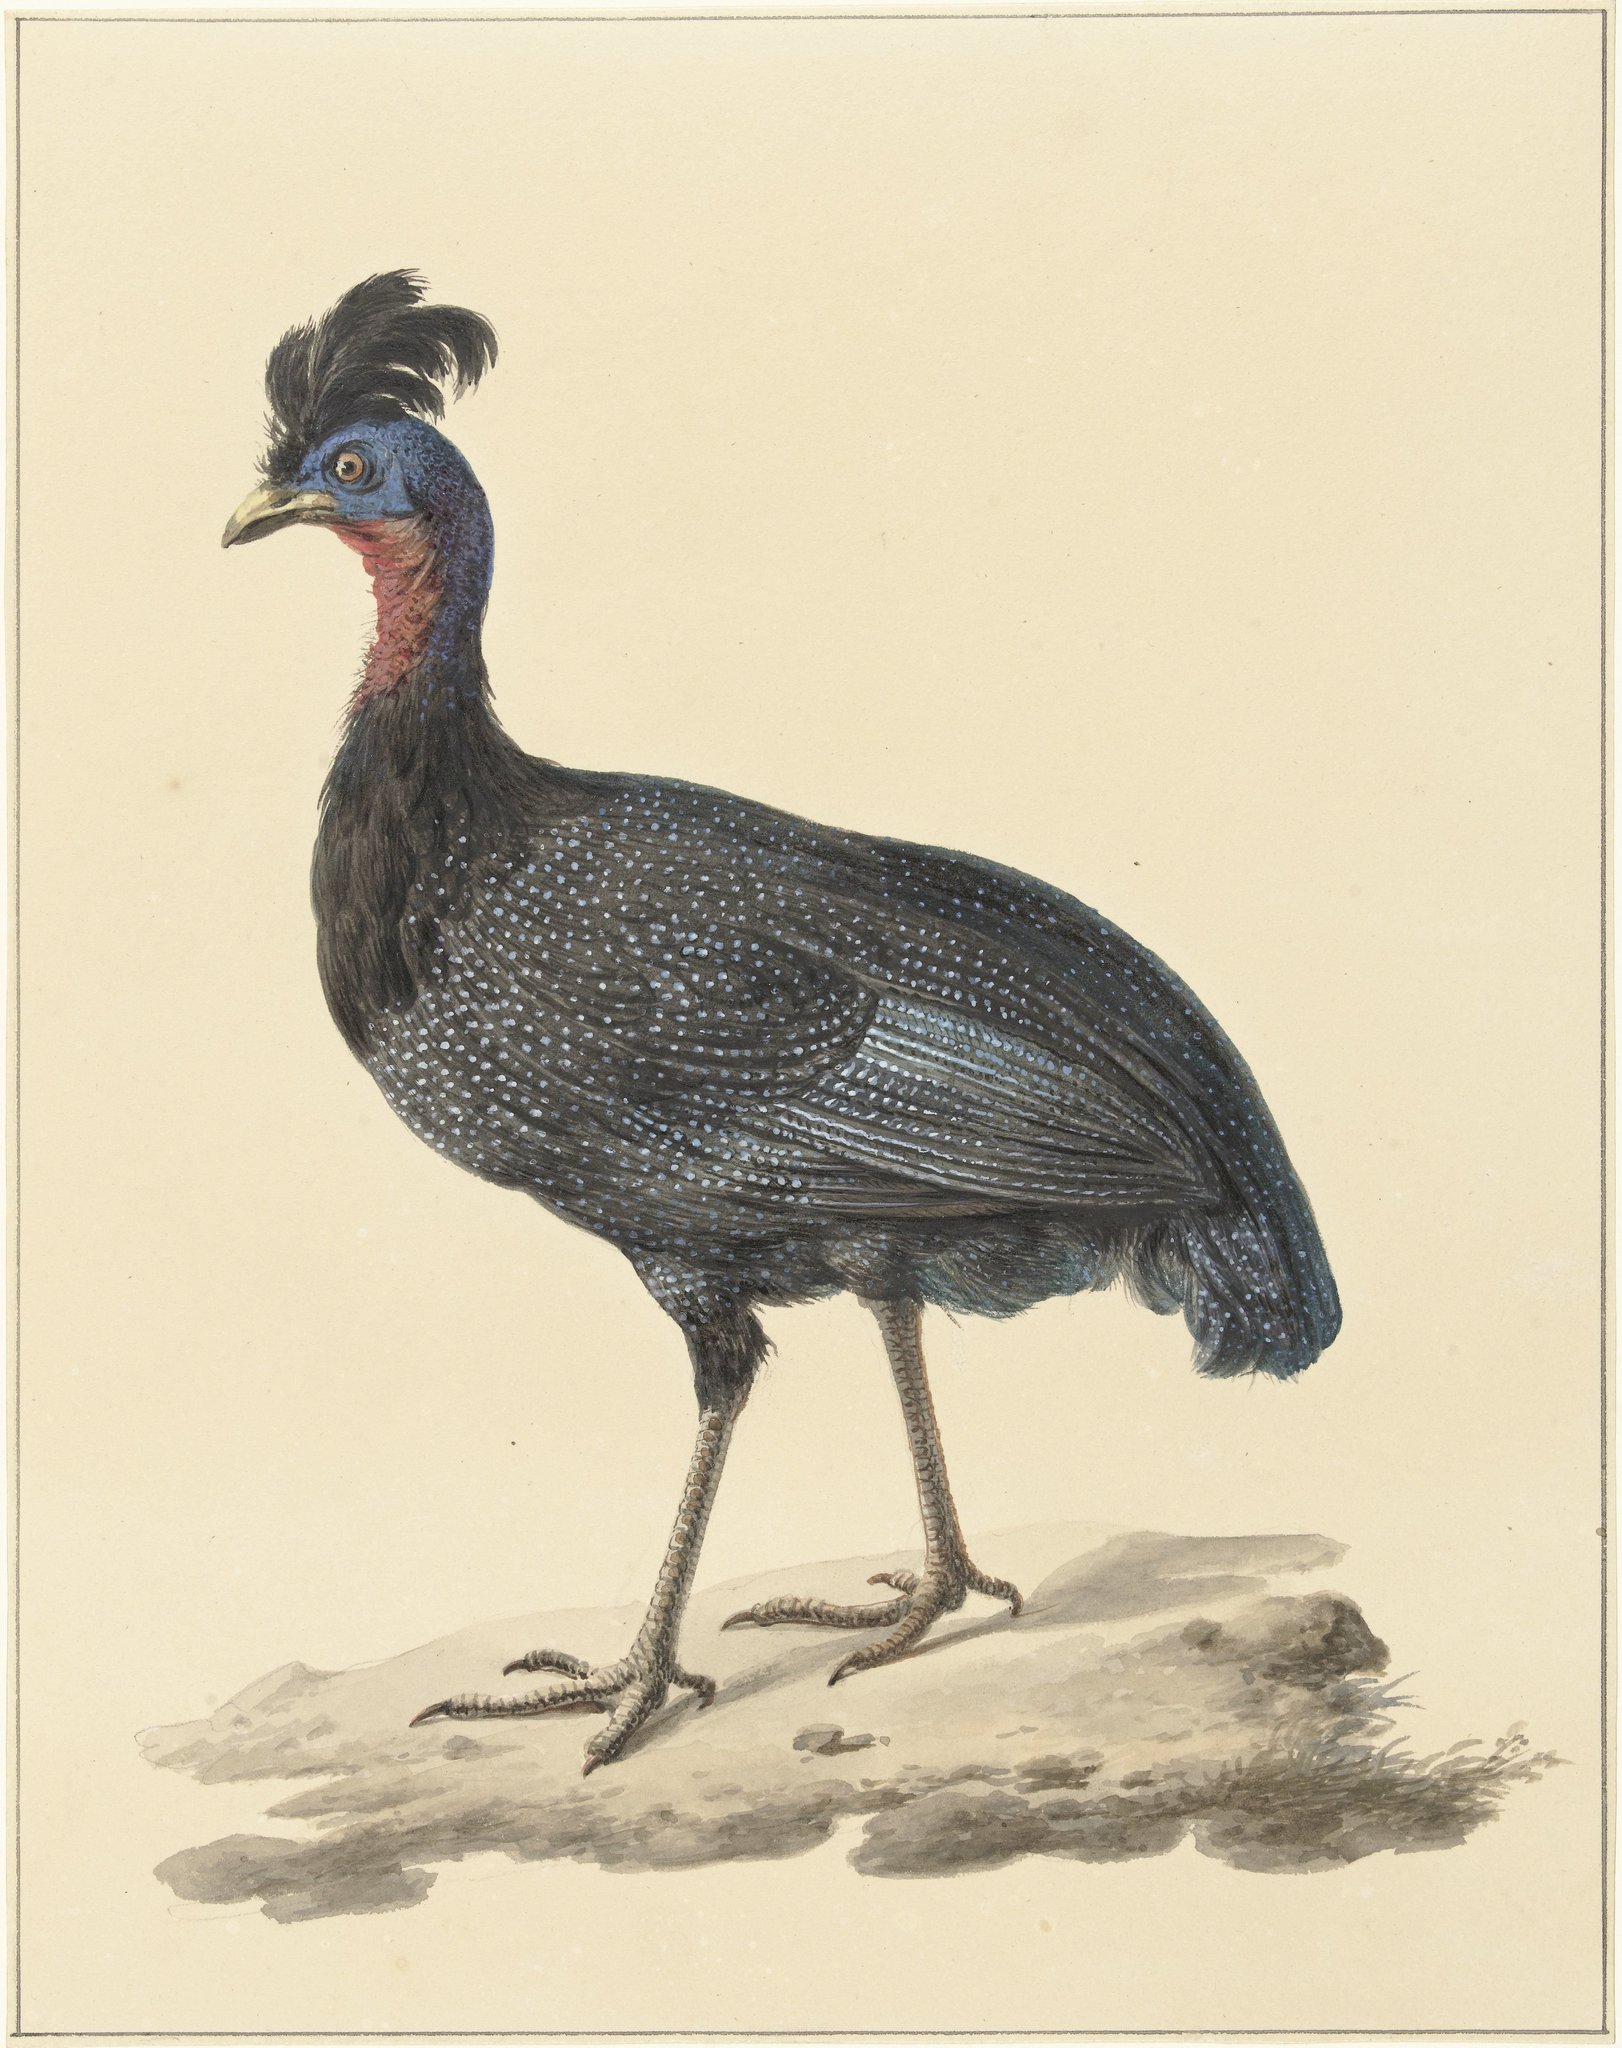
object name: watercolor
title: Kuifparelhoen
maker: pieter pietersz. barbiers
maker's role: draughtsman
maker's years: 1749-1842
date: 1759-1842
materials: paper, pencil, watercolor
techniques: brush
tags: walker and runner birds: guineafowl